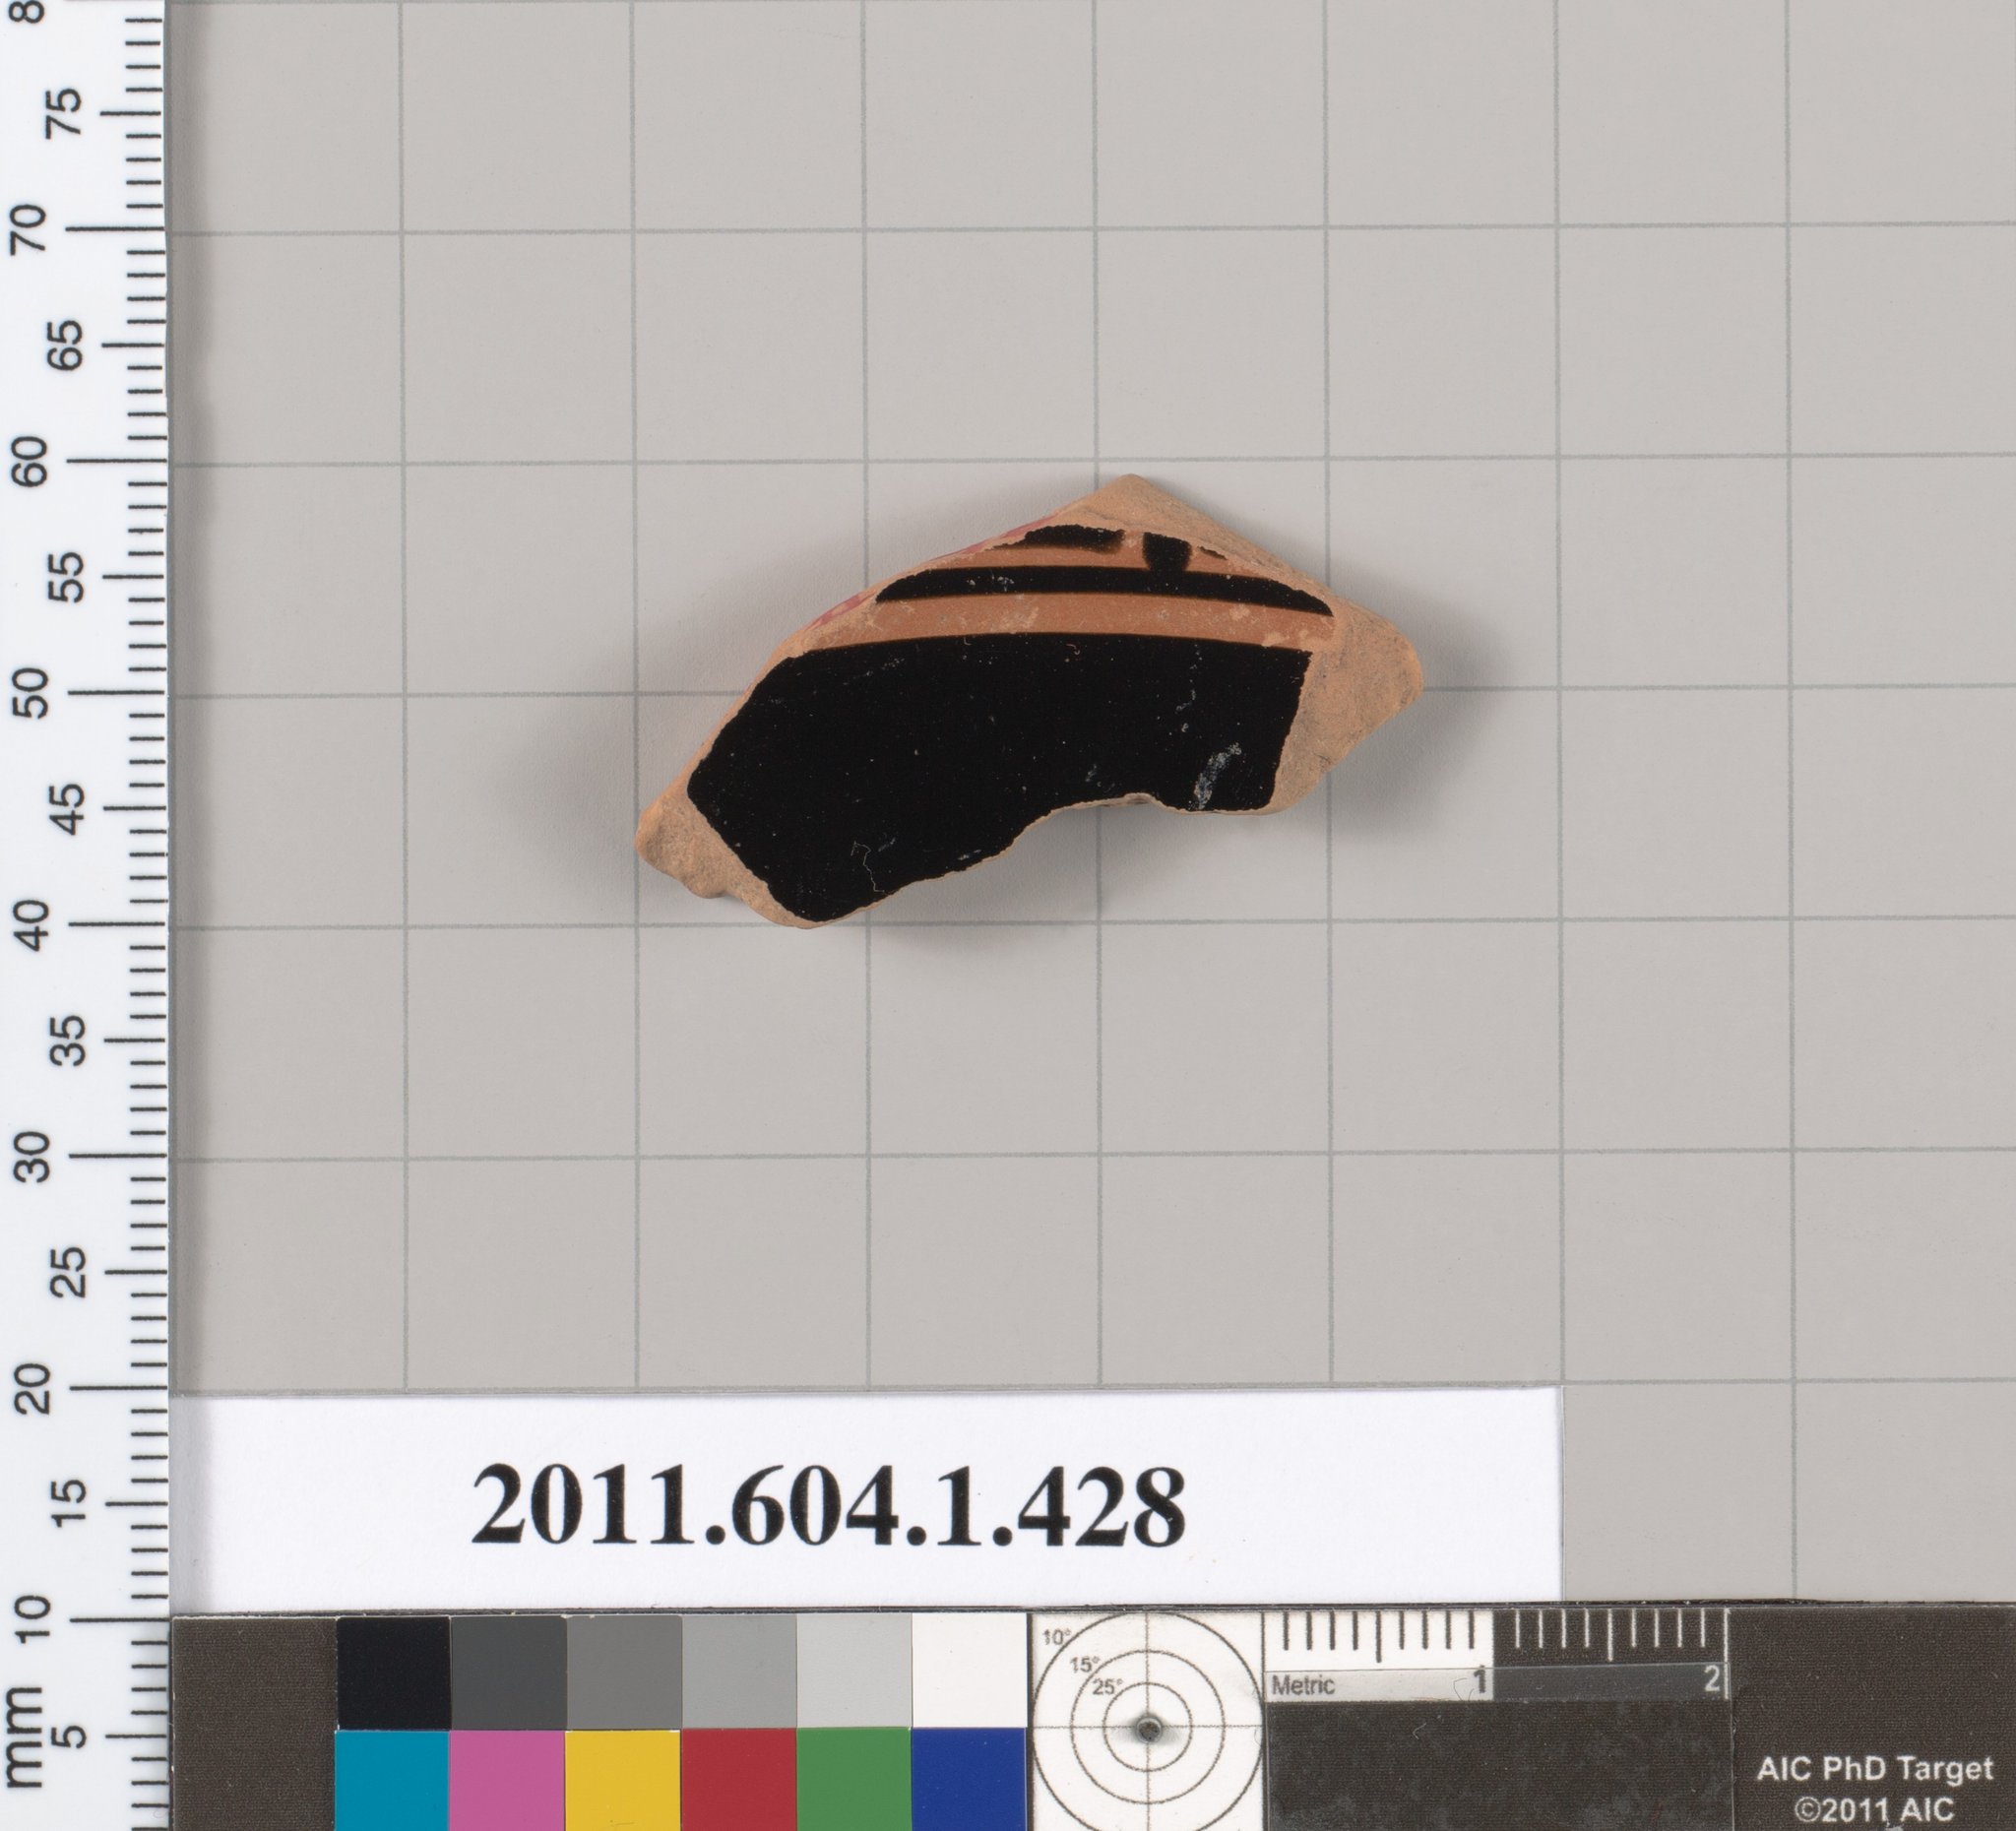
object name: kylix fragment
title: Terracotta fragment of a kylix (drinking cup)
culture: greek, attic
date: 475-451 BCE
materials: terracotta